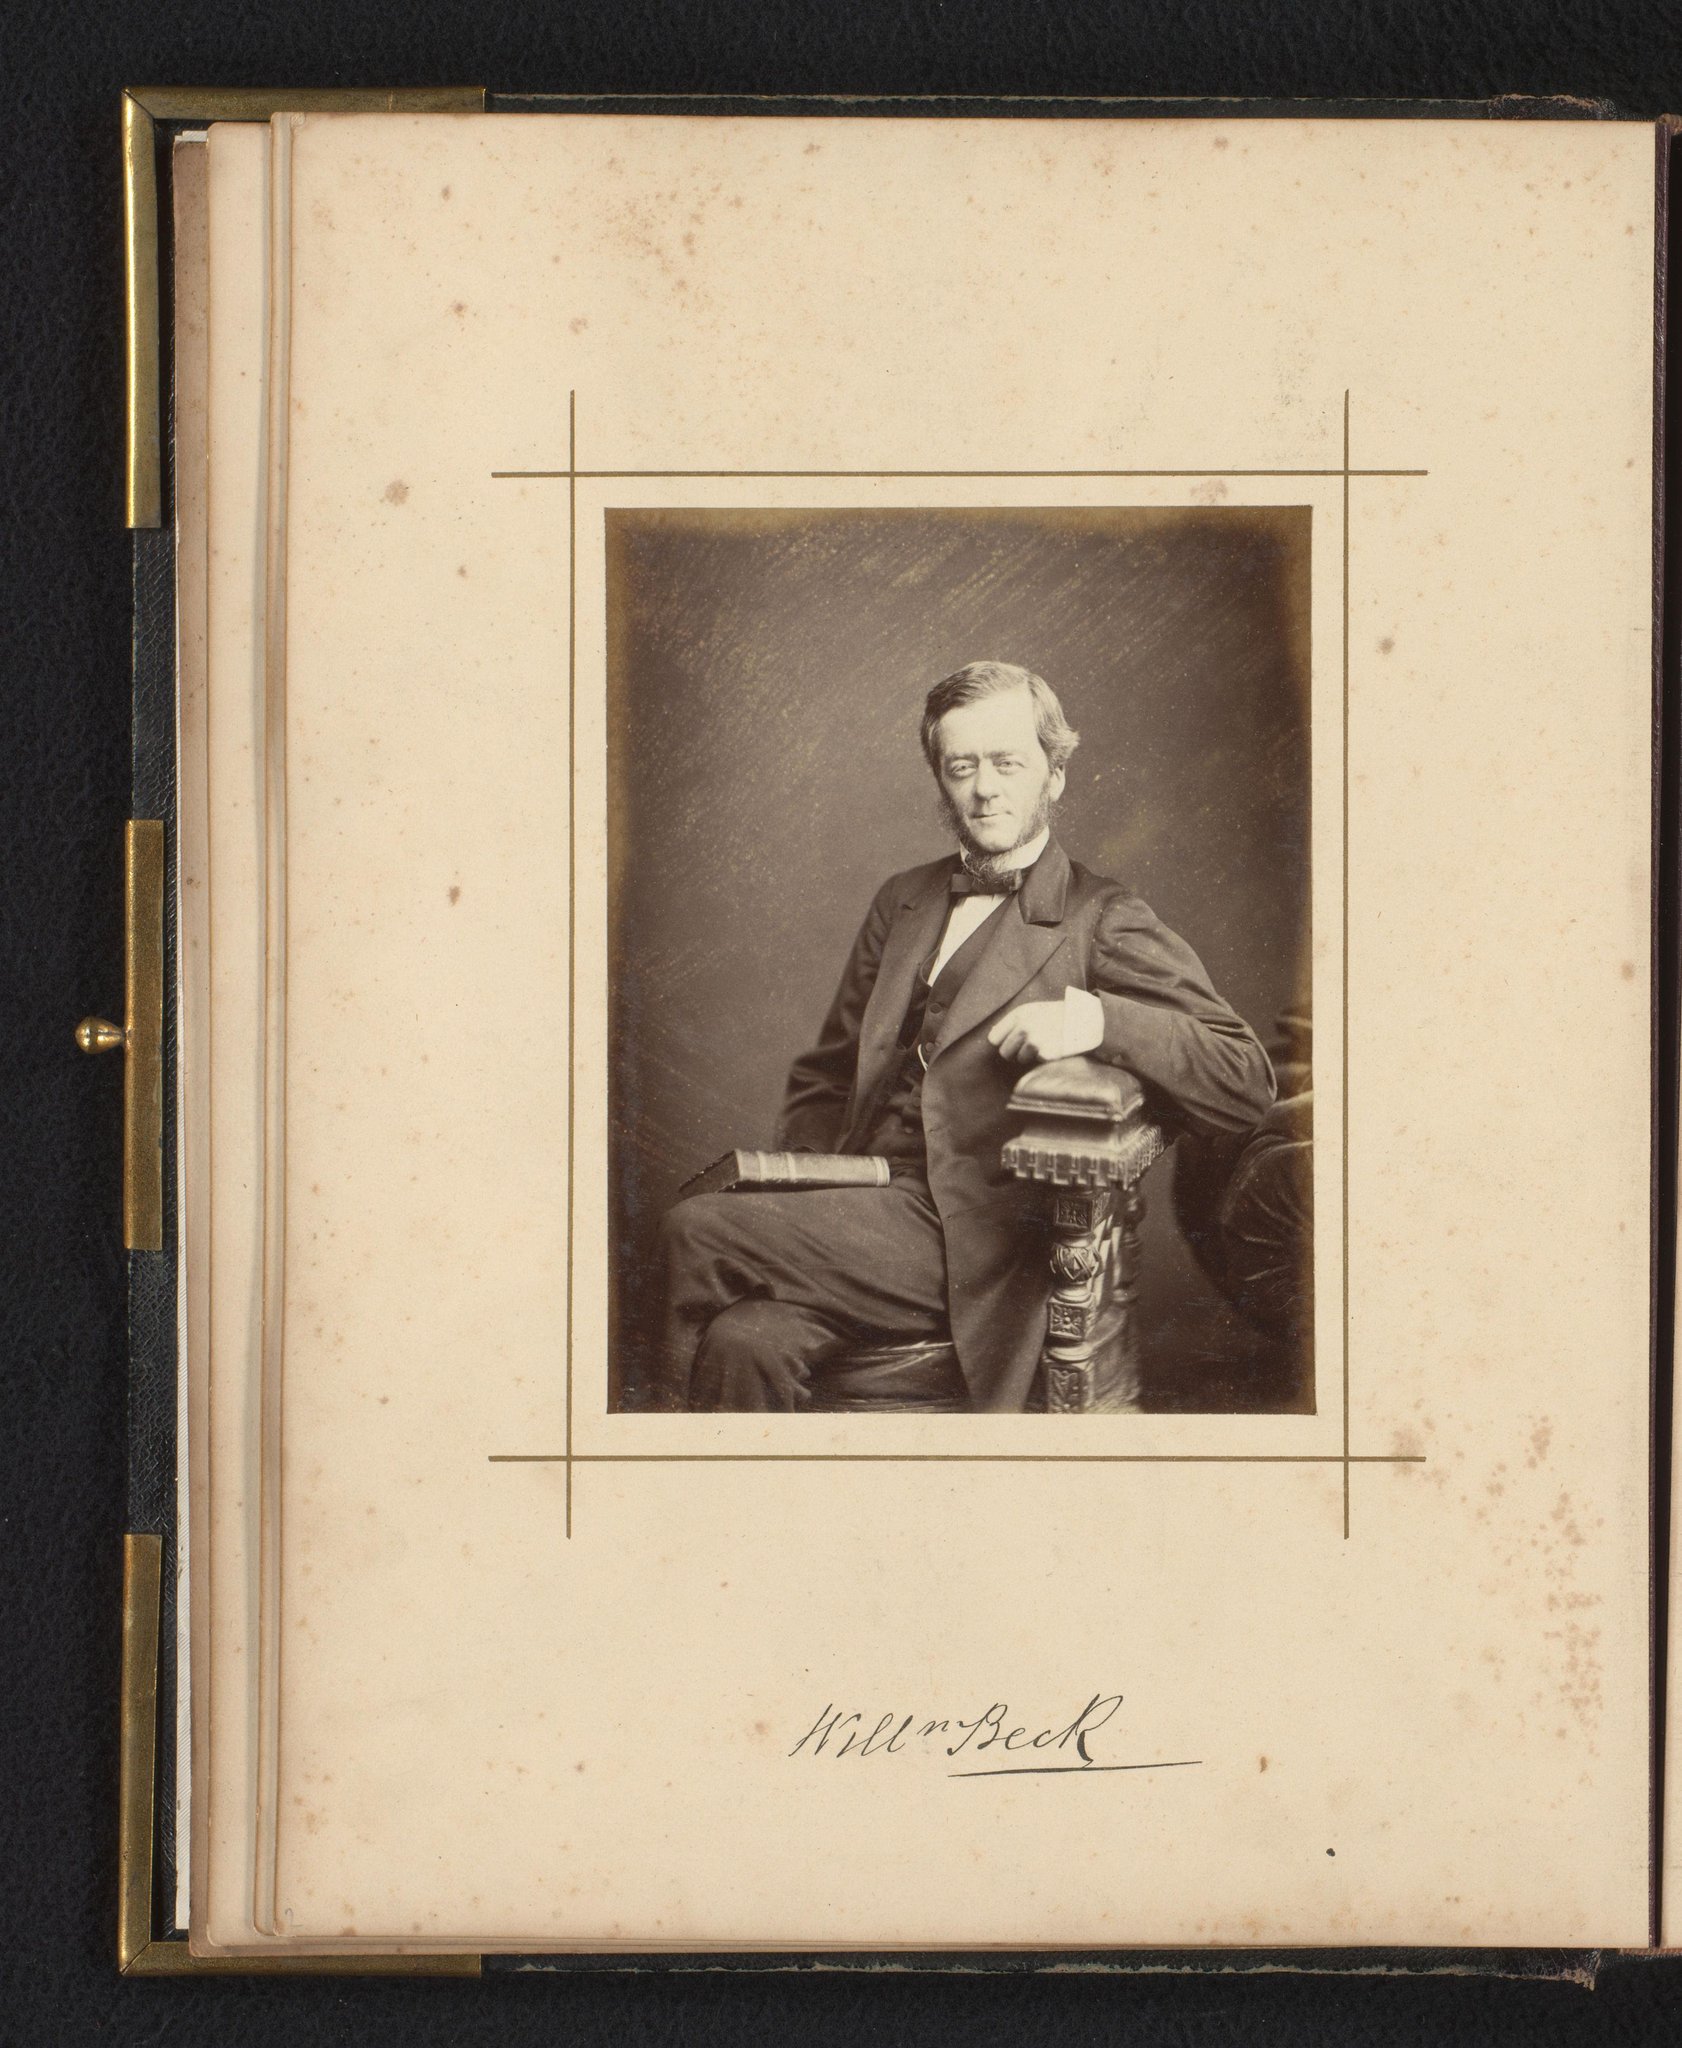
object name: page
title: Portret van een zittende man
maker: Anonymous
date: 1866-1871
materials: photographic support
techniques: albumen print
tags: historical persons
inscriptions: name: ‘[Hill n Beck]’